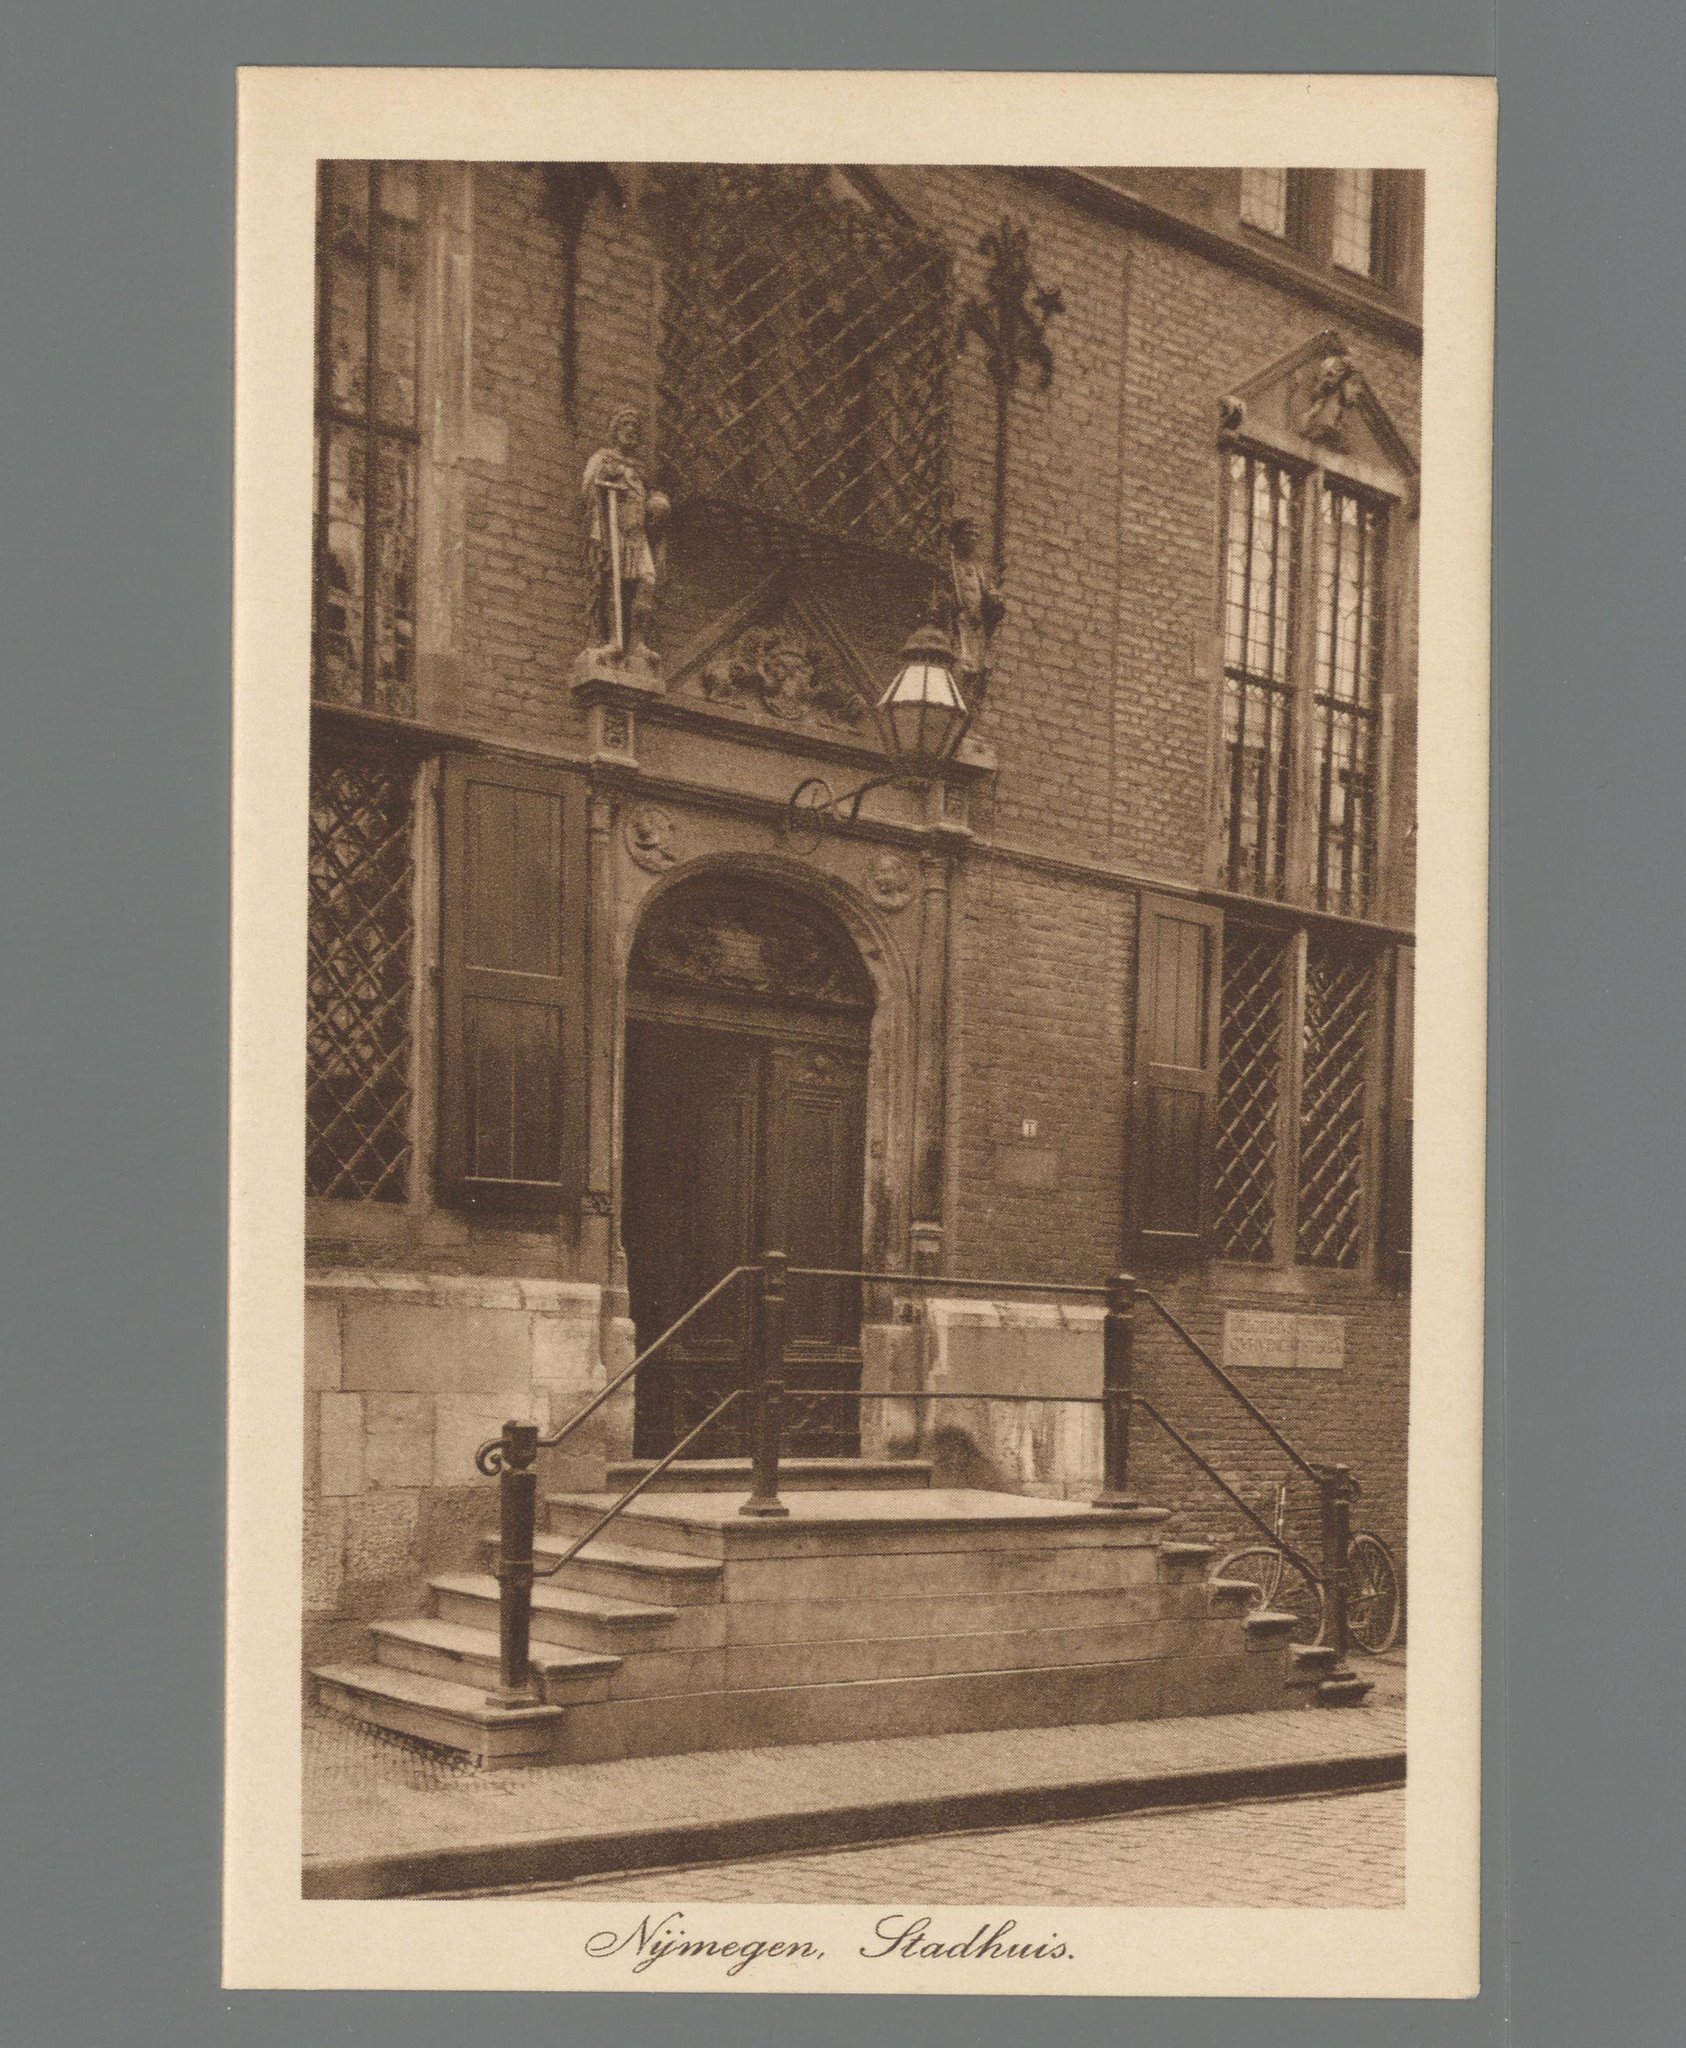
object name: photomechanical print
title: Nijmegen. Stadhuis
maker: Anonymous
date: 1919-1930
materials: cardboard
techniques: rotogravure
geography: nijmegen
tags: townhall